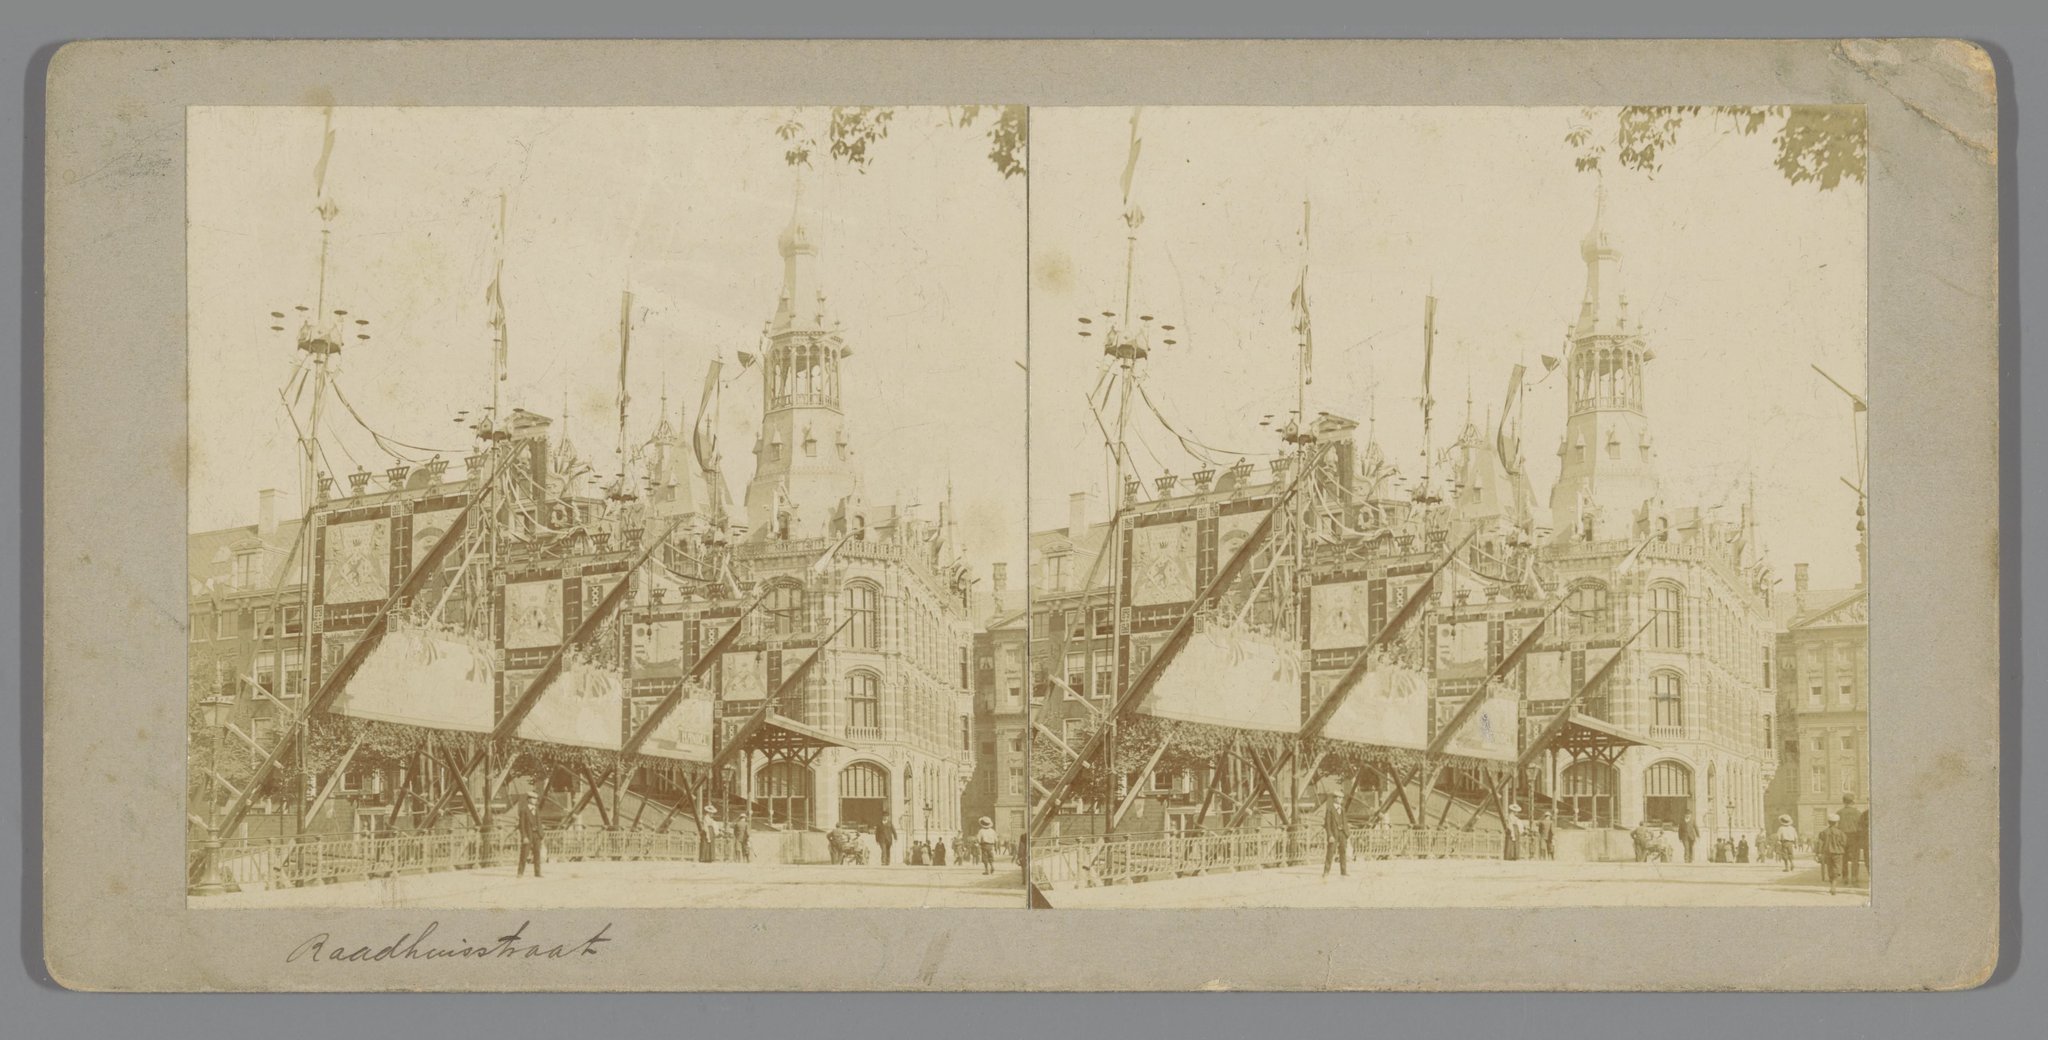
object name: stereograph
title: Raadhuisstraat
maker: Anonymous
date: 1898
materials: paper, cardboard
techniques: gelatin silver print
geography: amsterdam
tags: public festivities on the occasion of royal events, coronation of a ruler